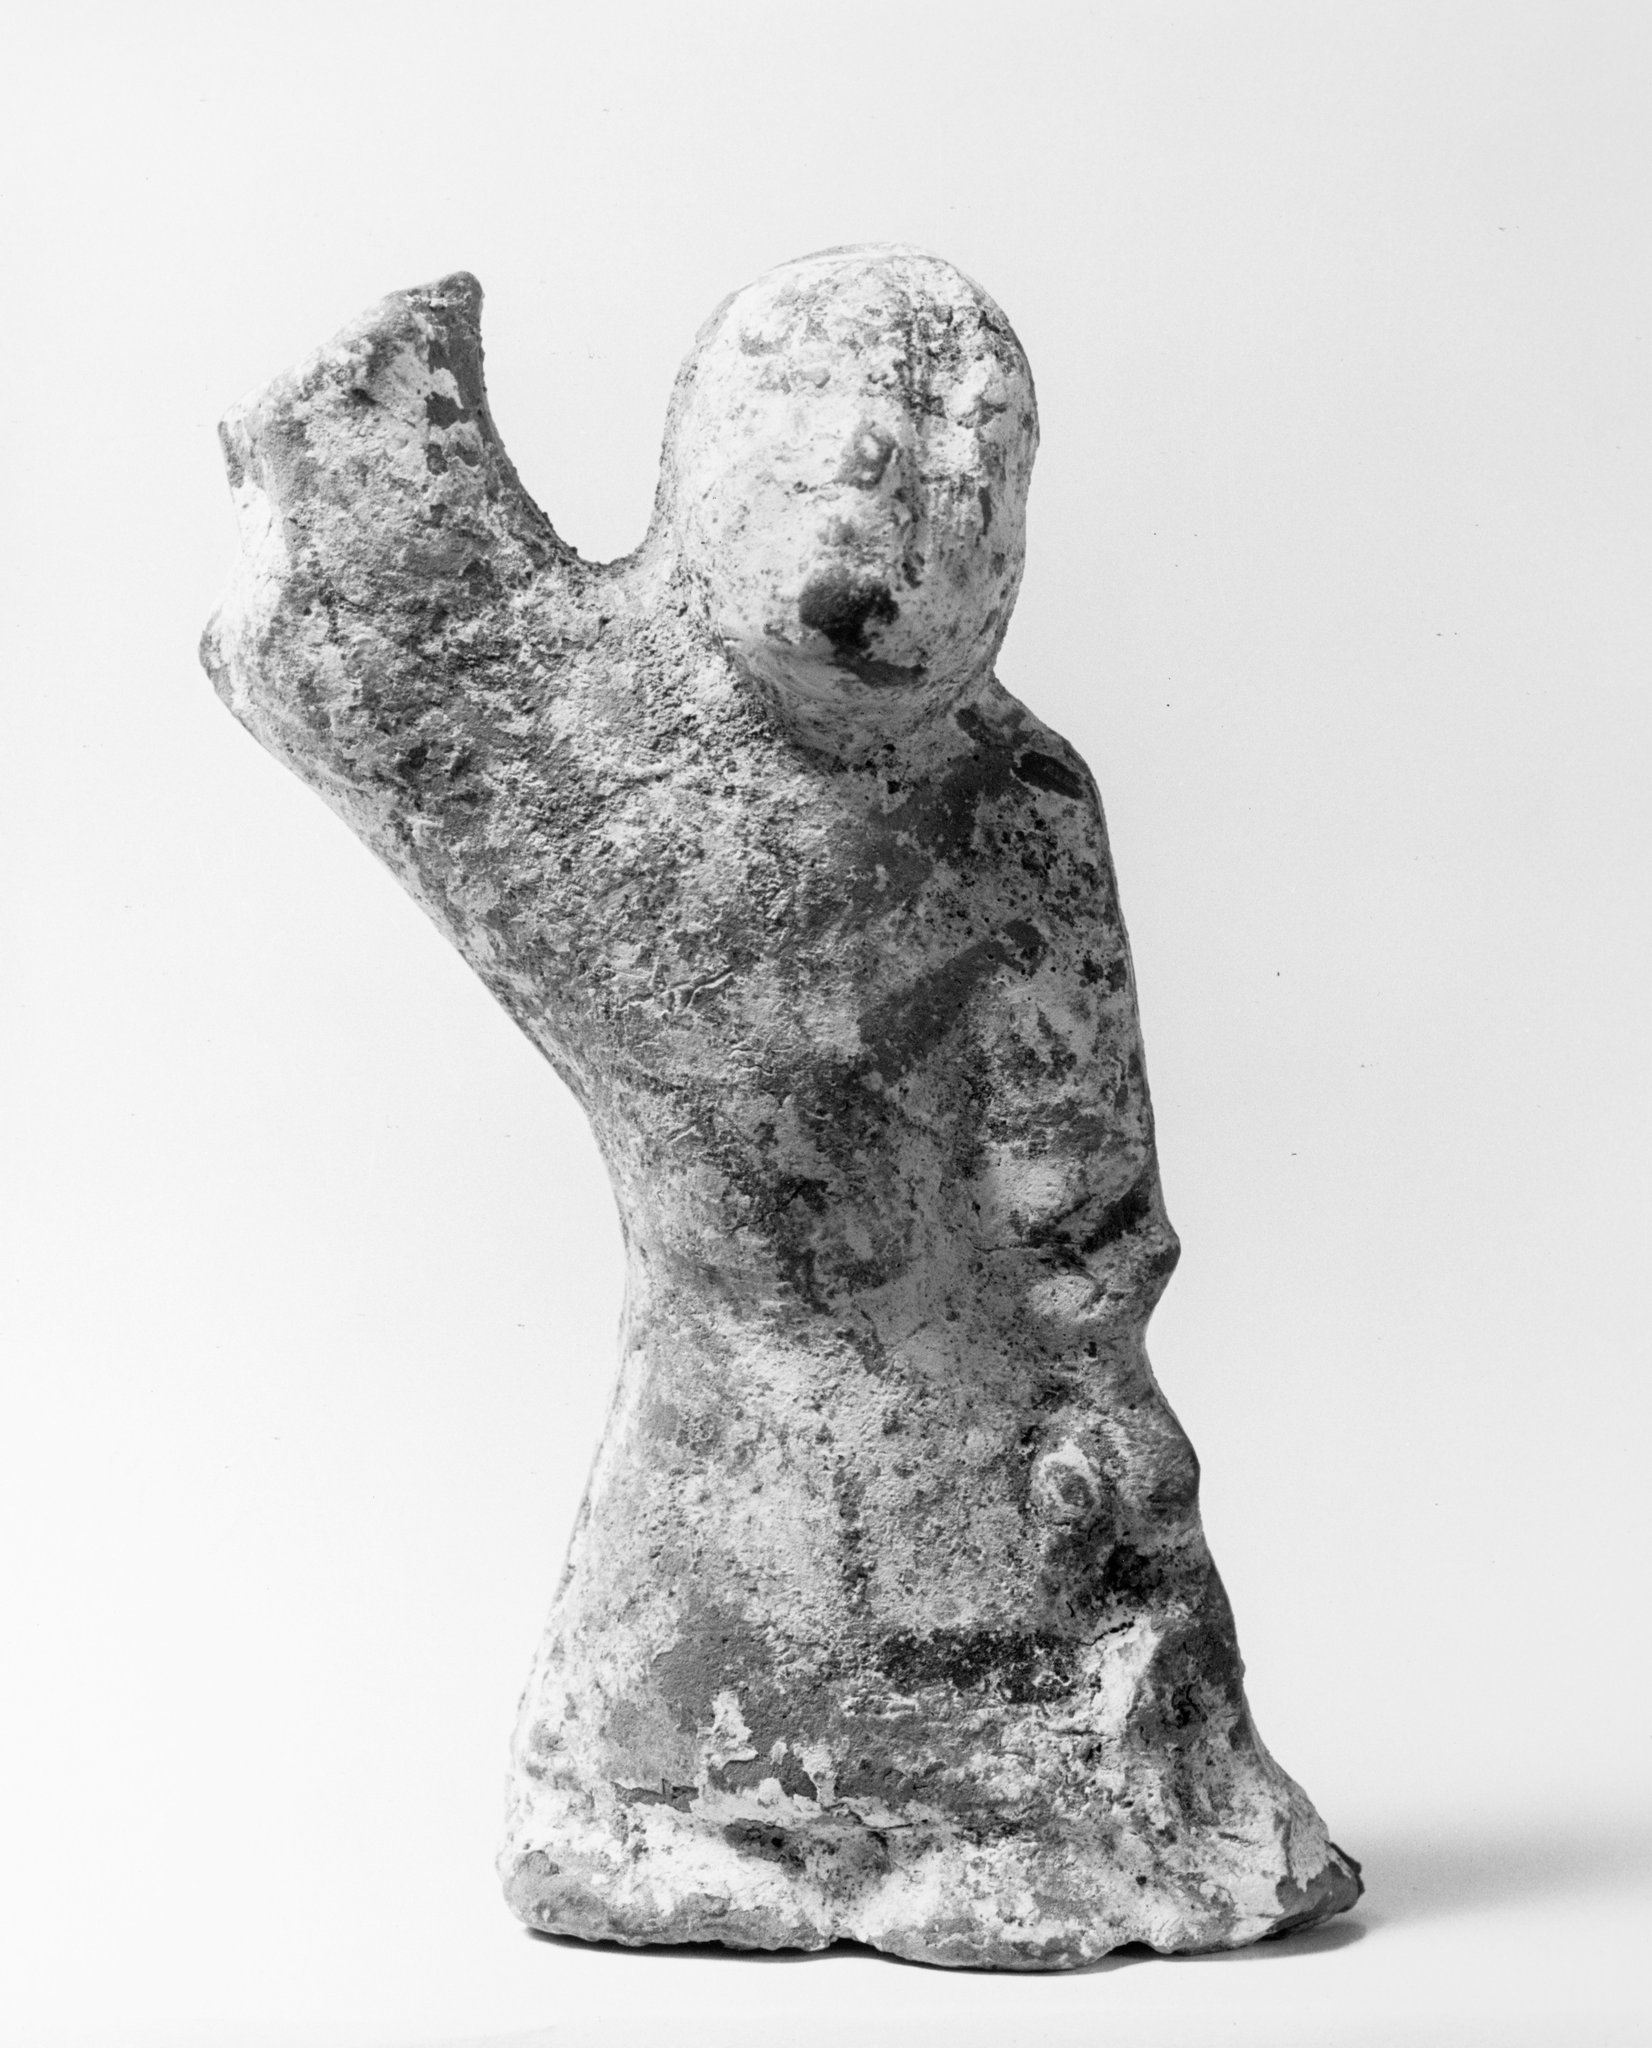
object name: tomb figure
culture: chinese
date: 206 BCE-220 CE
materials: paint, pottery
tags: human figures